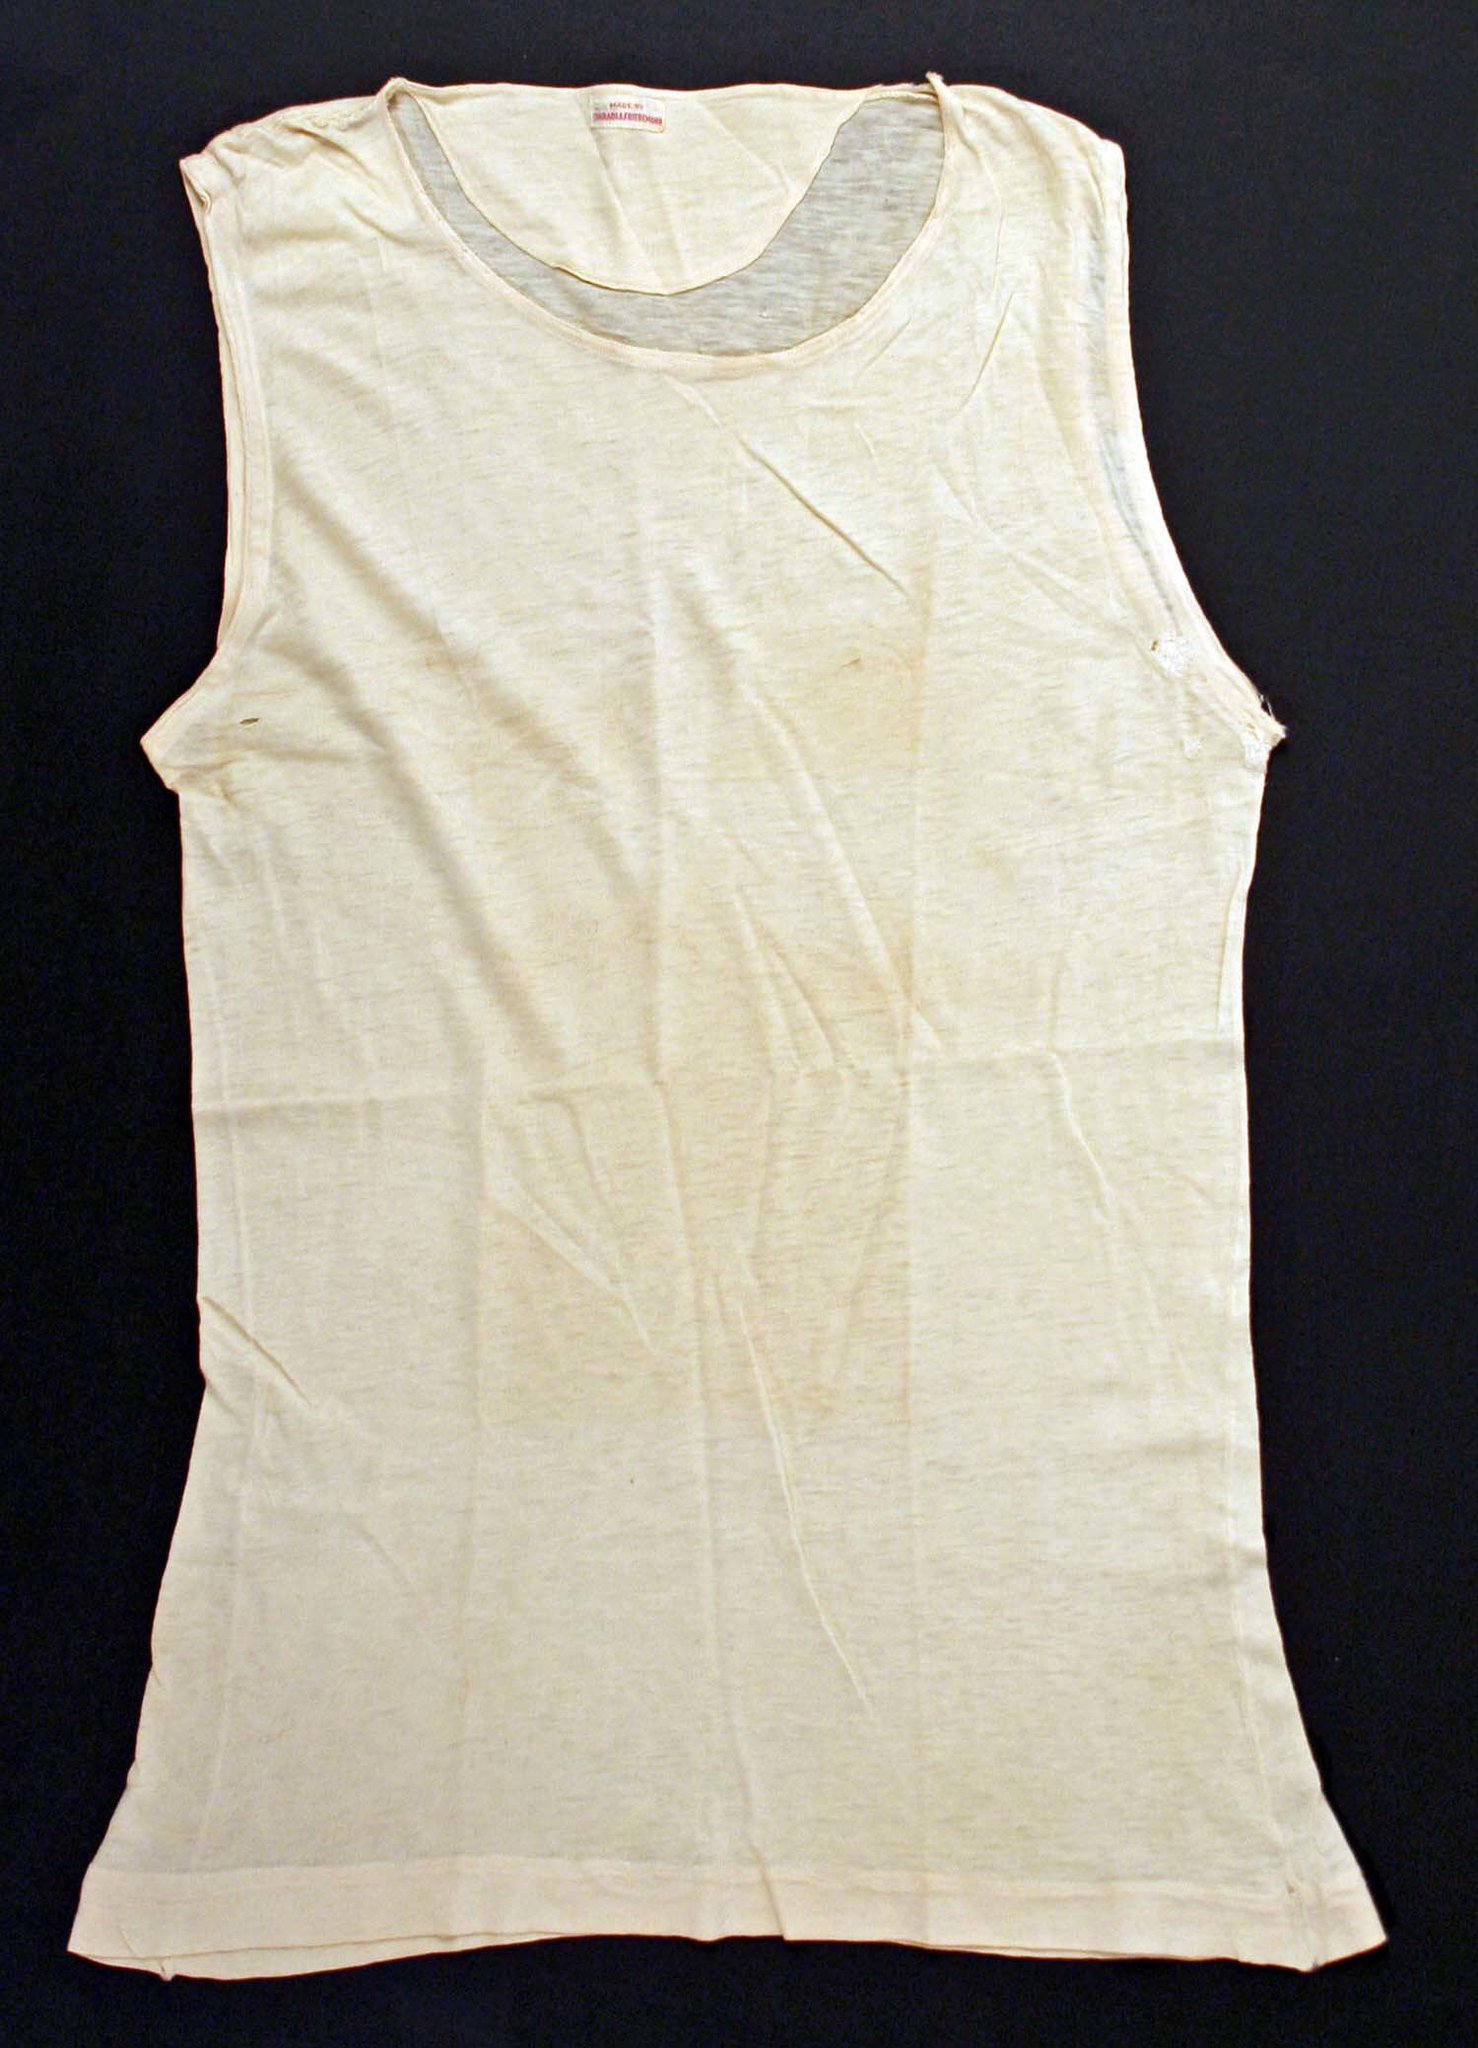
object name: undershirt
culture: american or european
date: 1900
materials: cotton